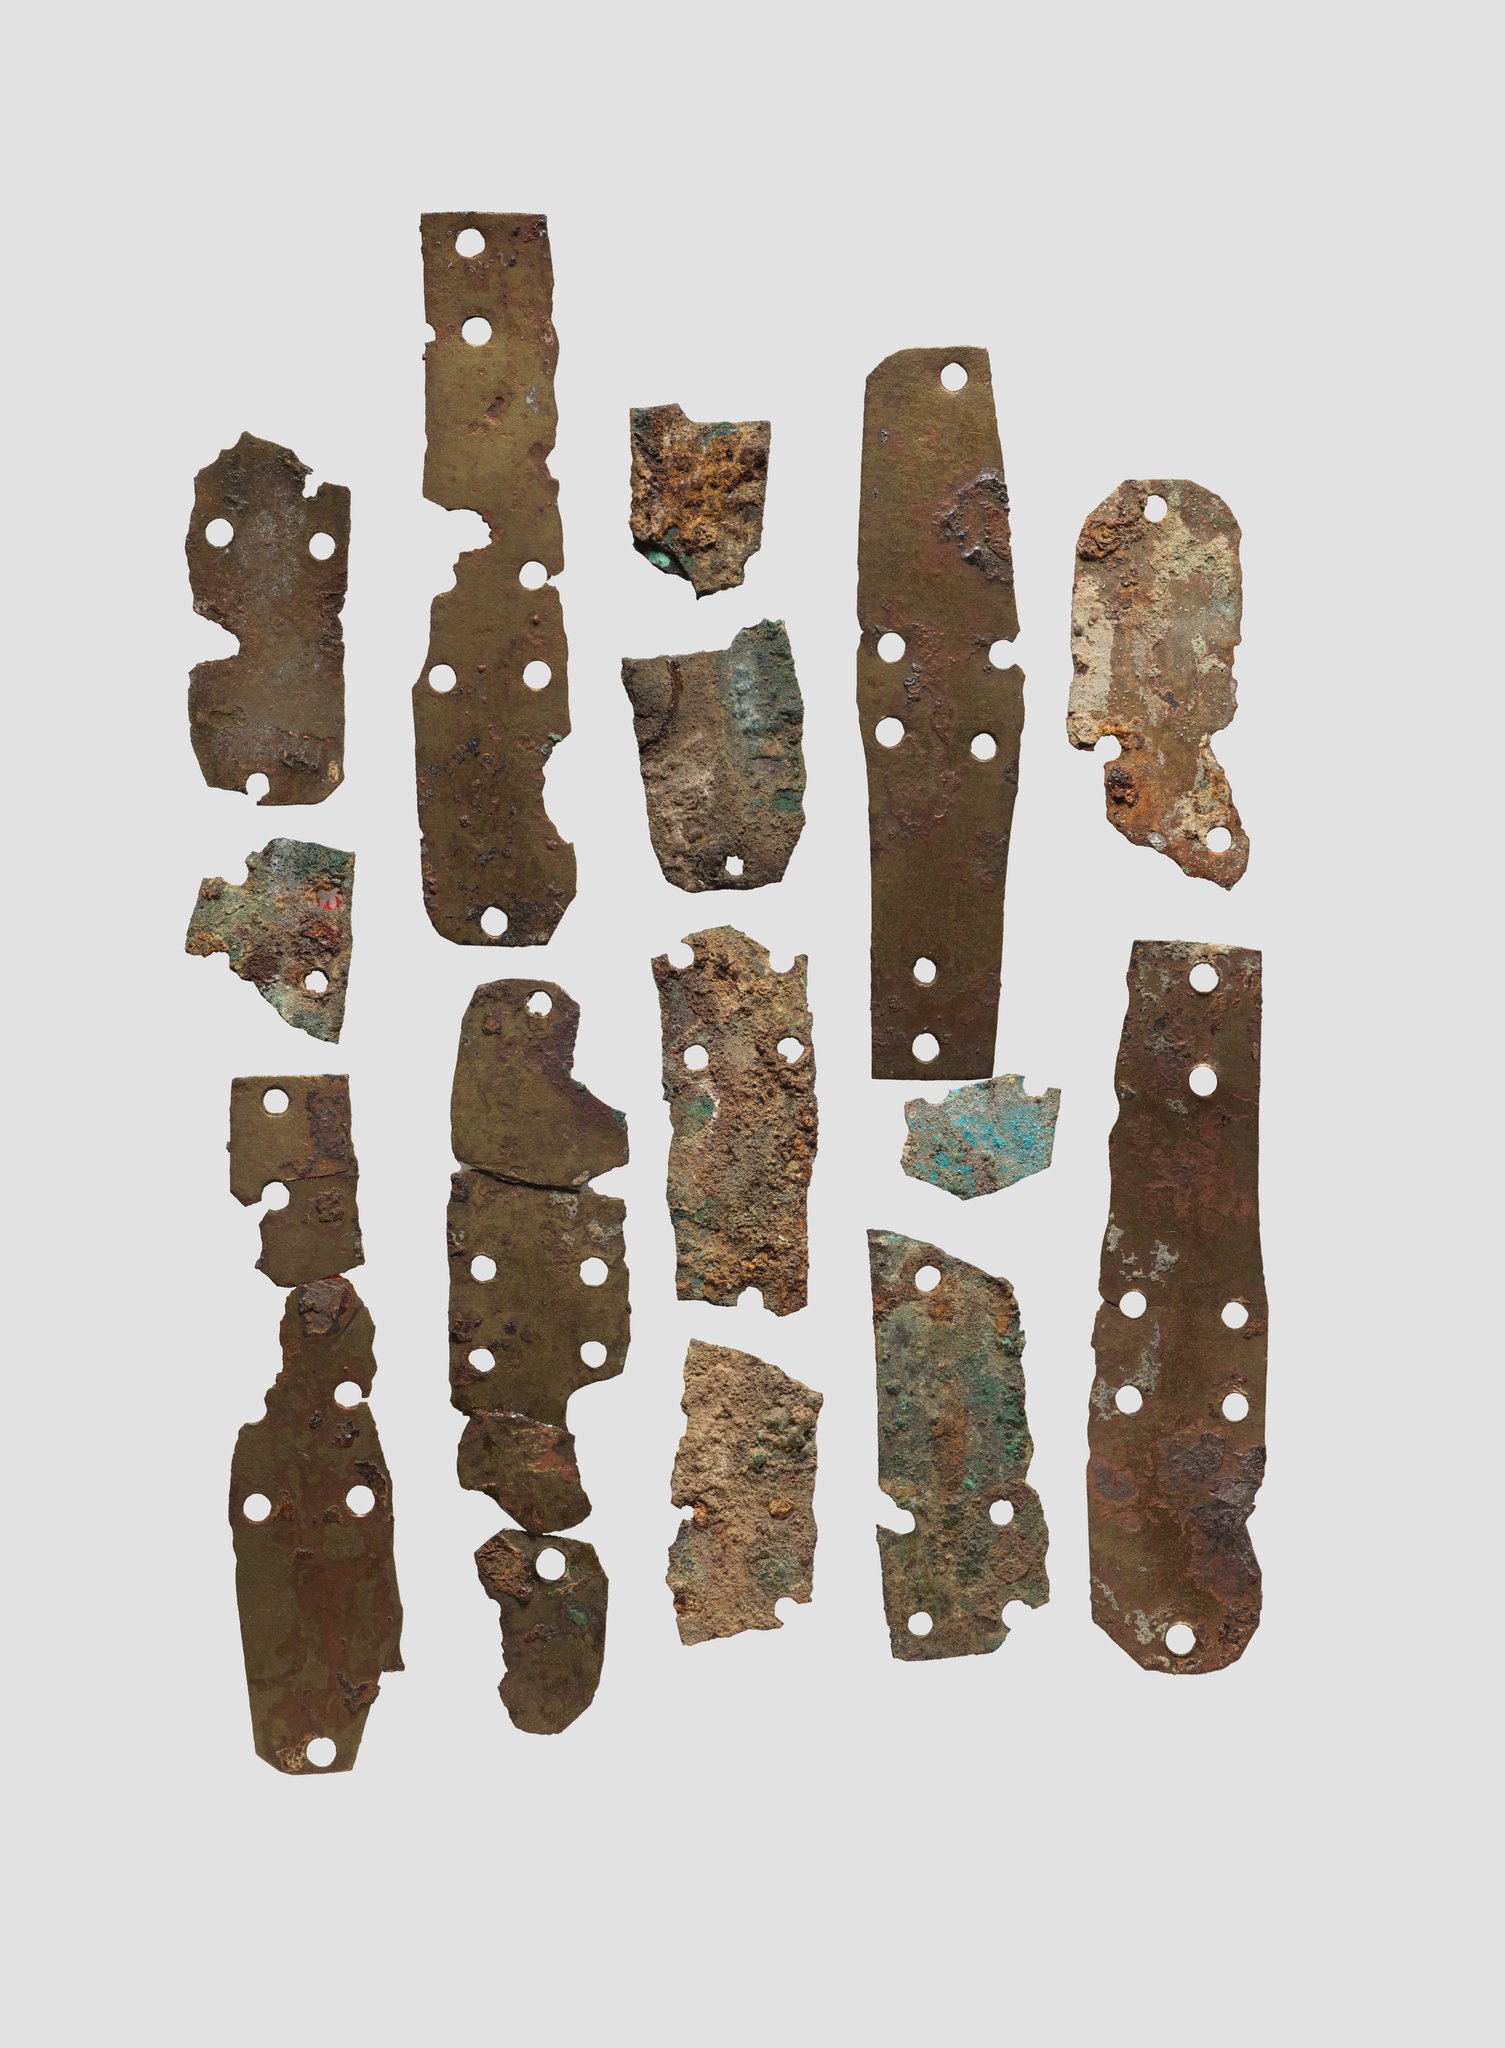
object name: armor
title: Splint armor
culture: sasanian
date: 201-700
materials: bronze, iron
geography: iran